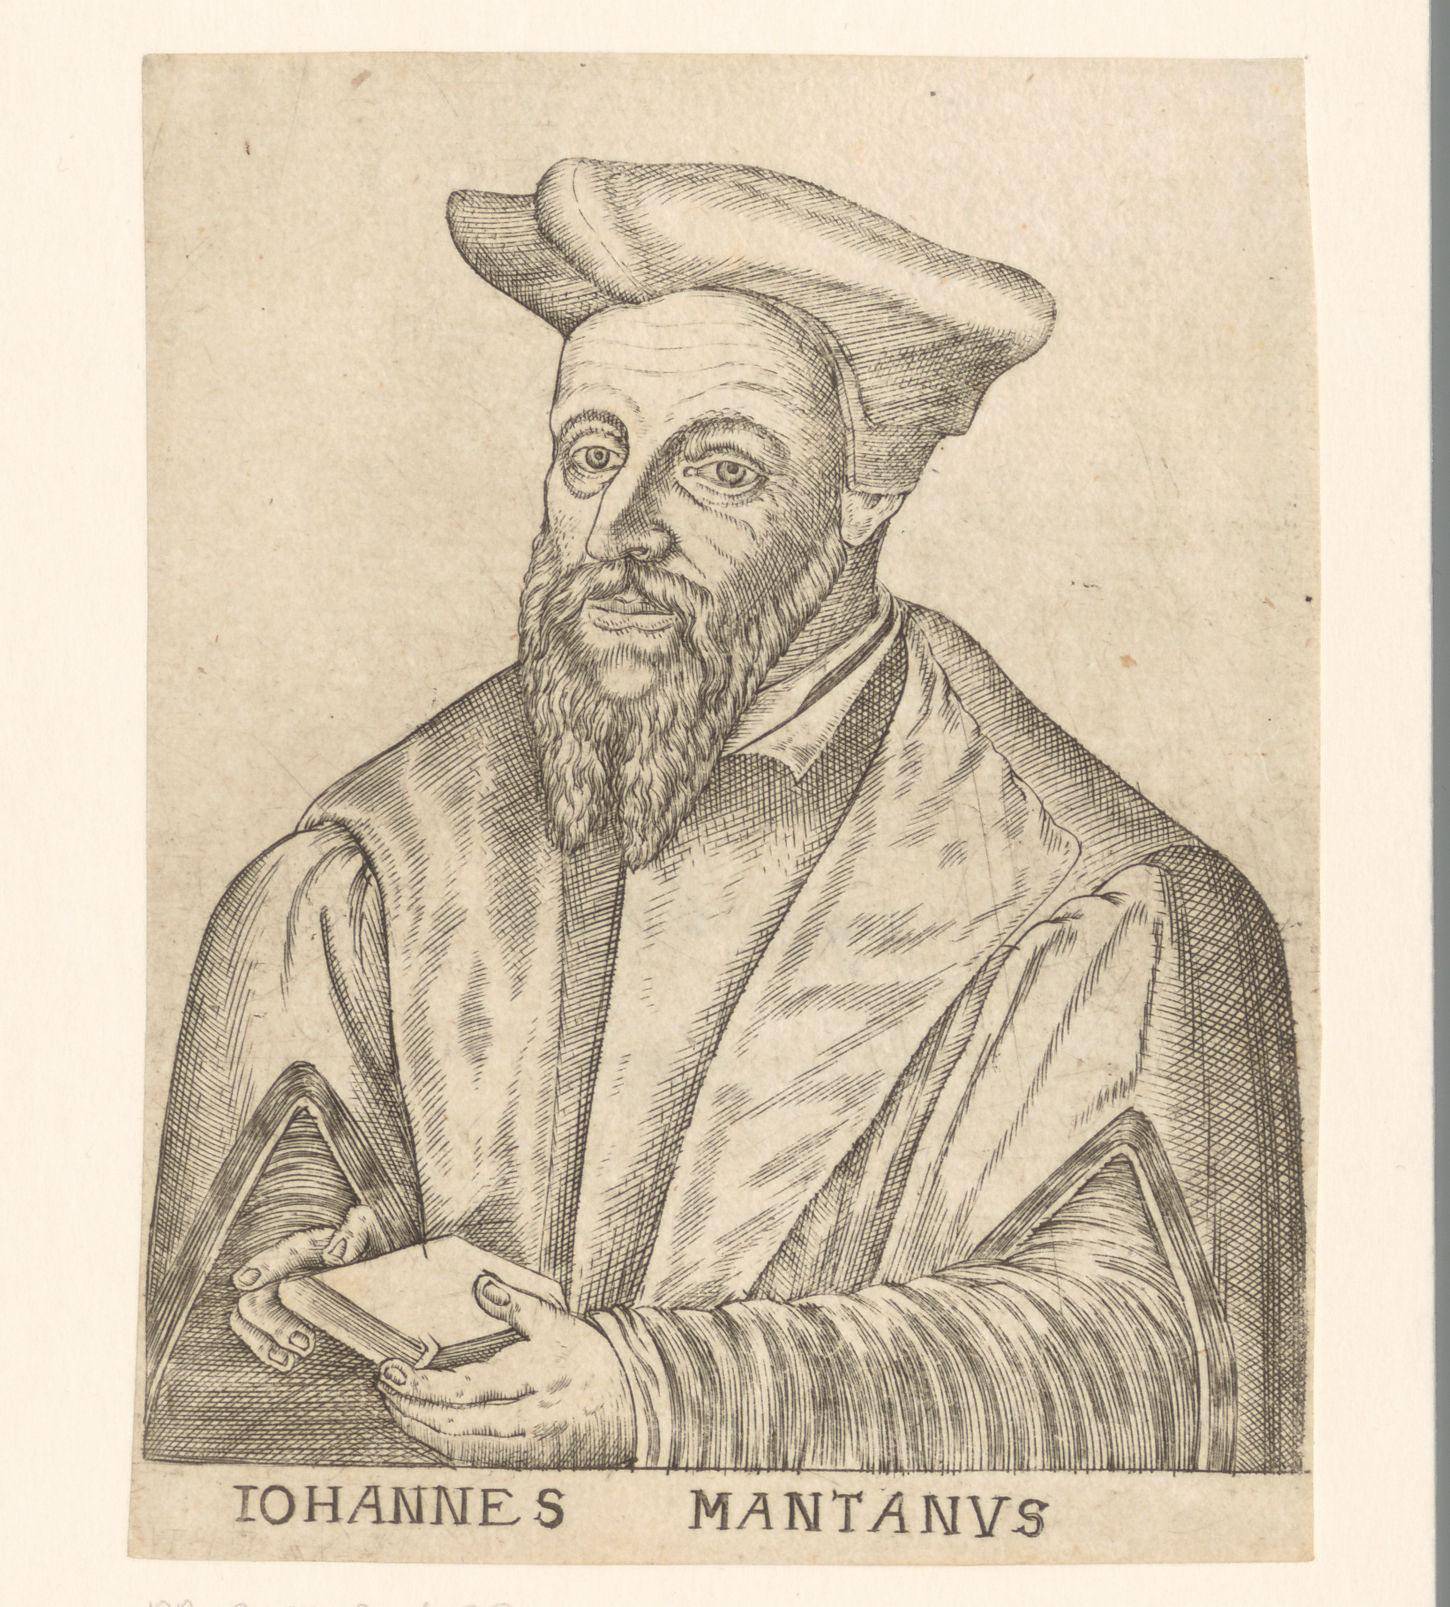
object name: print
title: Portret van Johannes Baptista Montanus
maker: Anonymous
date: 1563-1642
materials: paper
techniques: engraving, etching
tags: historical persons, physician, doctor (+ portrait of scholar, scientist)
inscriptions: collector's mark: Lugt 2228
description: Deze kopie van een prent door Balthasar Jenichen hoort bij een serie portretten van sturende personen tijdens de reformatie, gebruikt in: Agricola, Johann. Bildnüs und Abcontrafactur etzlicher Vornemer Gelerten Menner, durch welche Gott aus sonderbaren gnaden, die rechte reine Warheit des heiligen Evangelii, zu diesen unsern und beschrieben (...). Dresden: Gimmel Bergen, 1588.